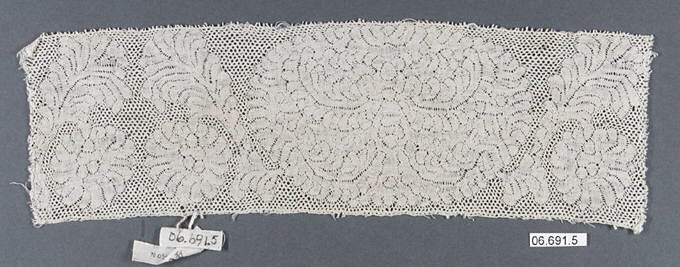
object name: piece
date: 1701-1800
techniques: lace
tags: flowers,leaves